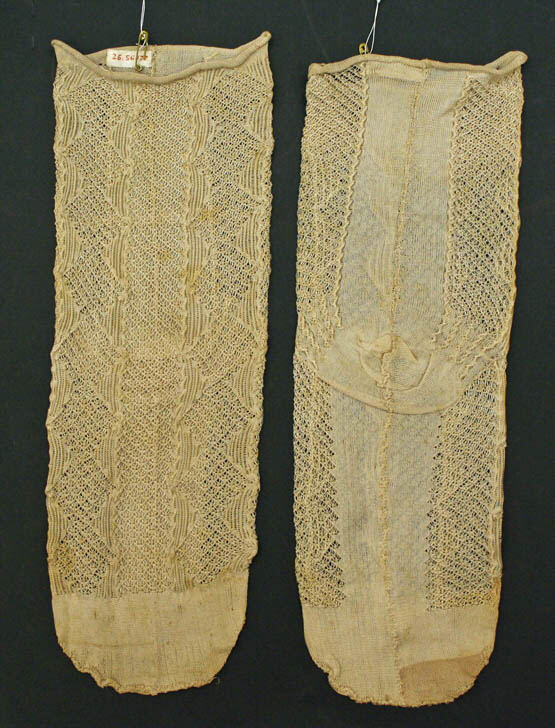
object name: sock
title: Socks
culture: italian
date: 1801-1833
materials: silk